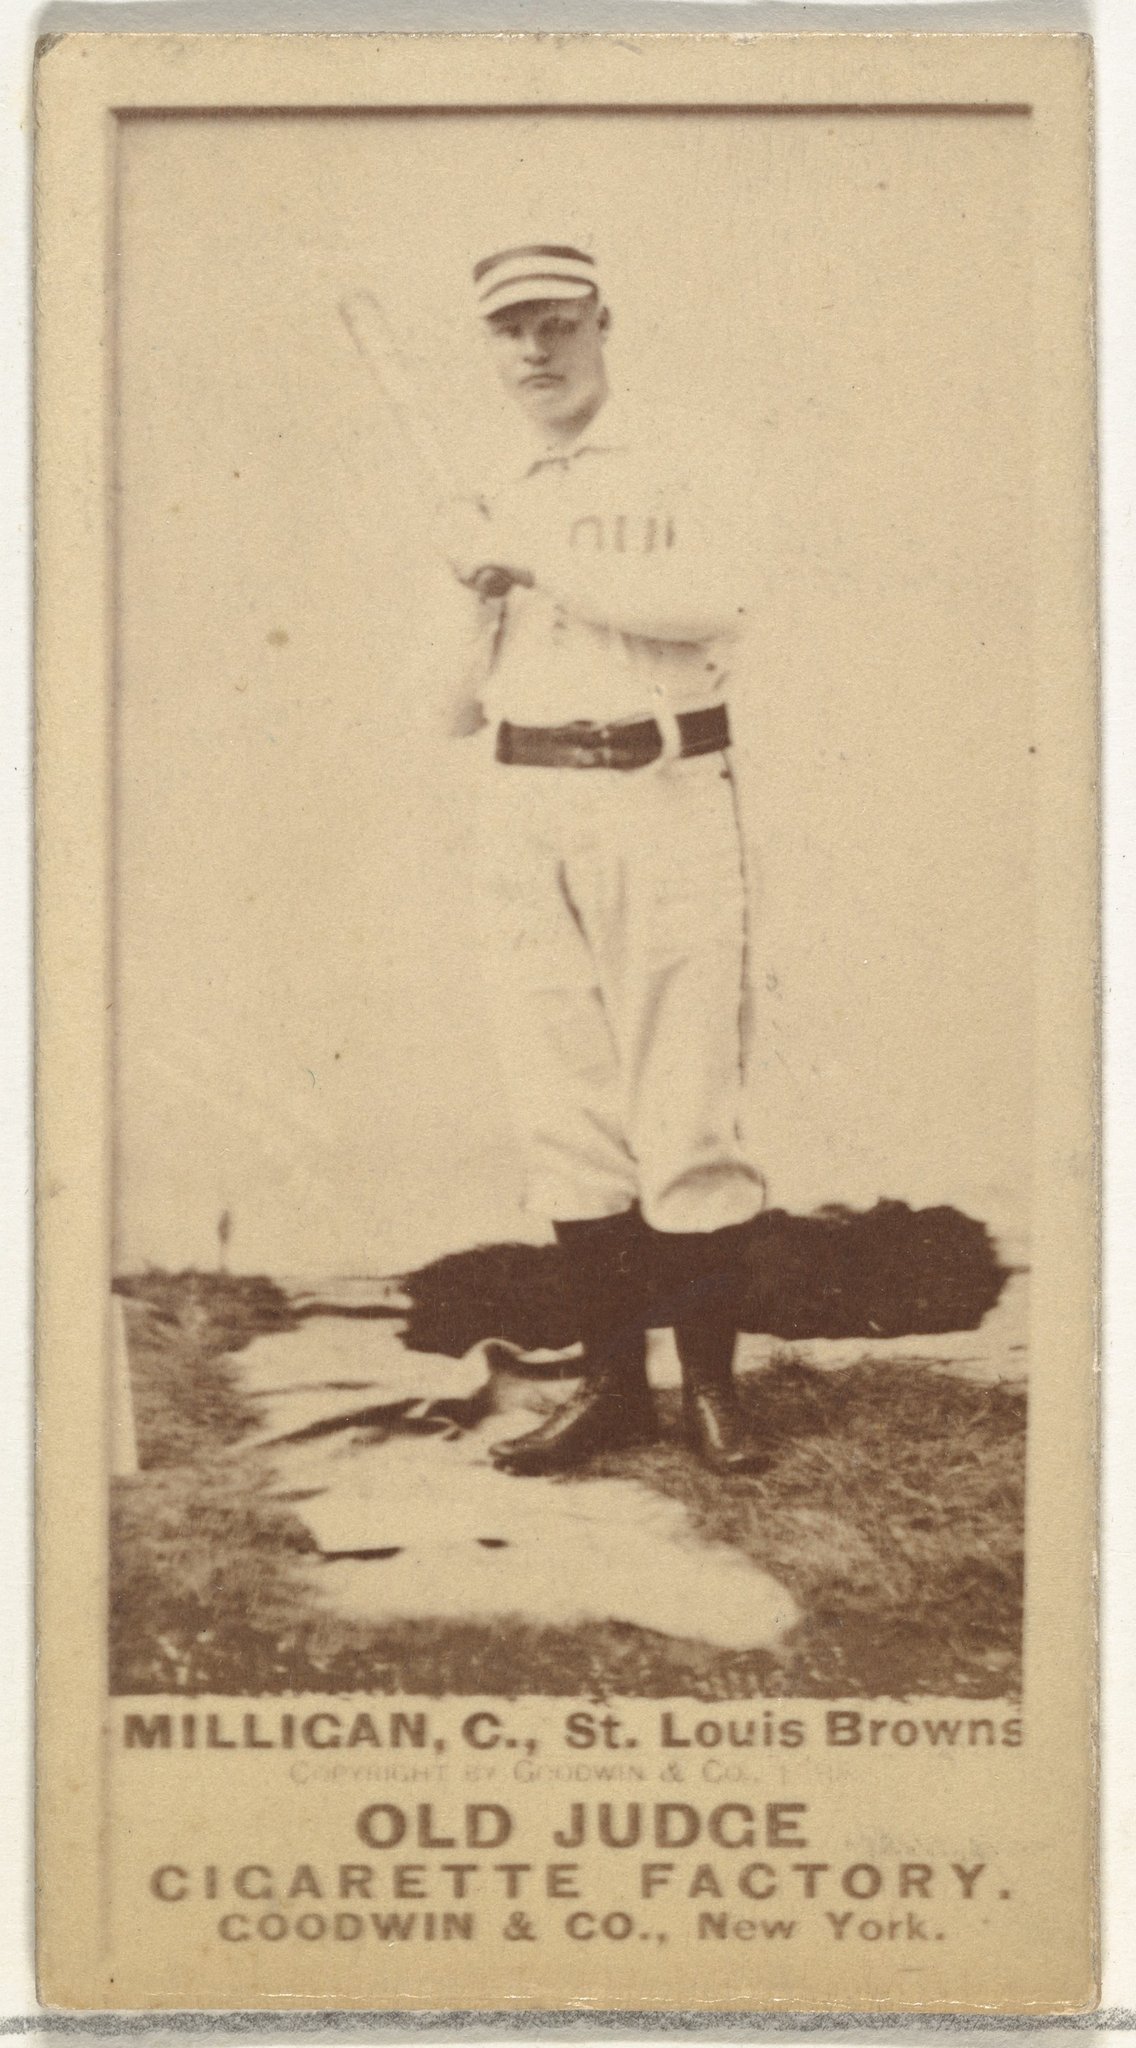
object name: baseball card, photograph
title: Jocko Milligan, Catcher, St. Louis Browns, from the Old Judge series (N172) for Old Judge Cigarettes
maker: goodwin & company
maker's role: publisher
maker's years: 1850-1950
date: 1887-1890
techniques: albumen silver print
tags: men,portraits,baseball,athletes